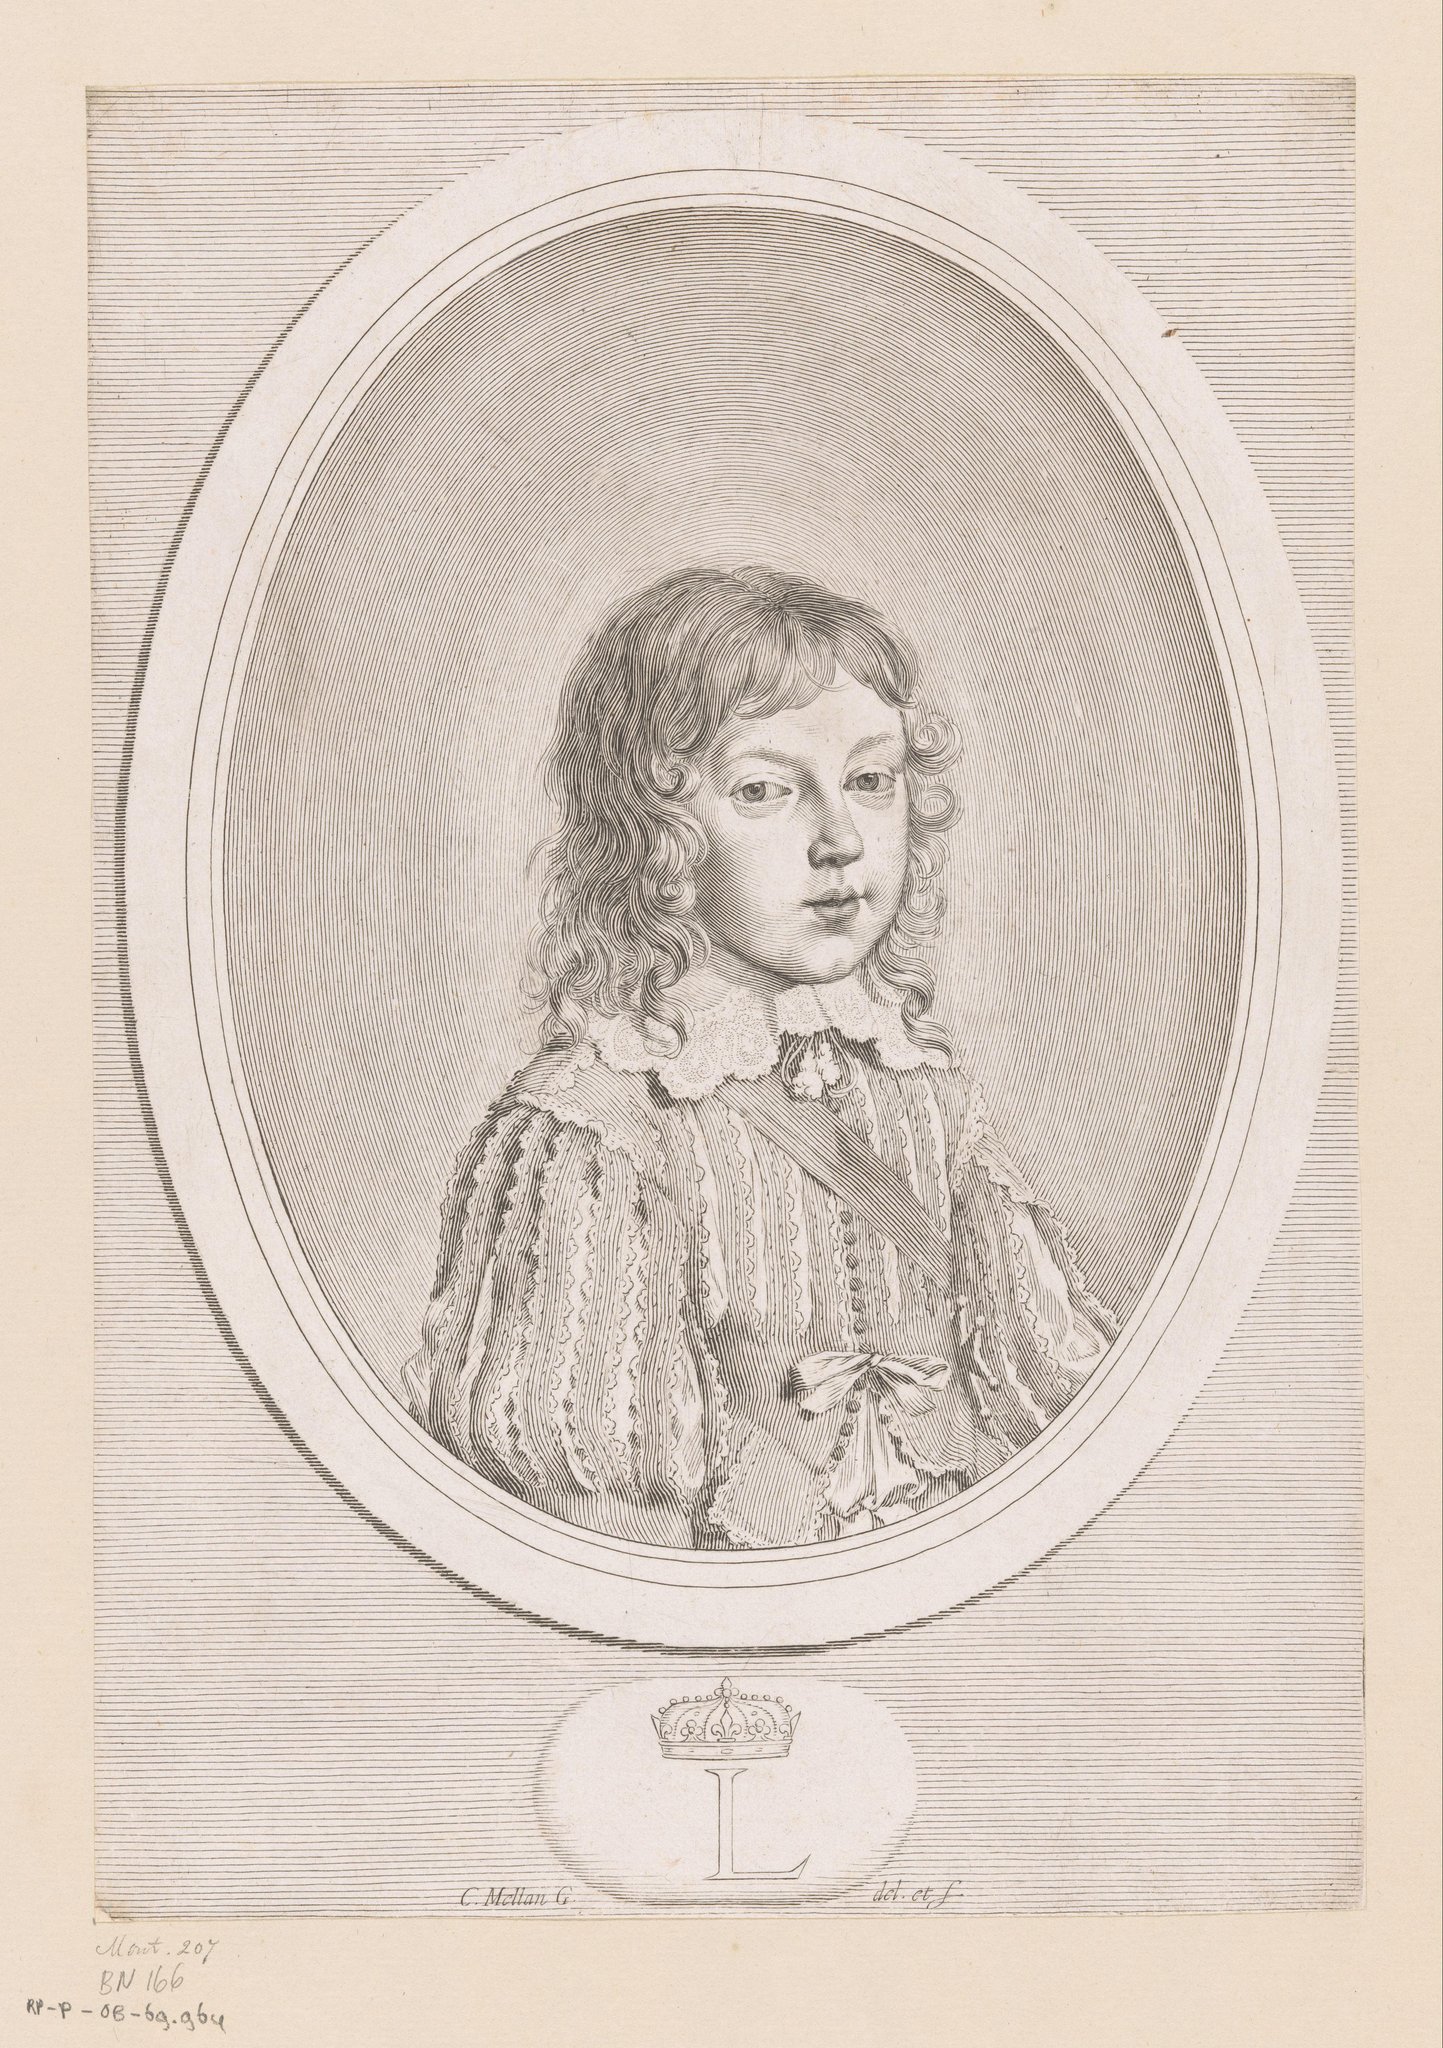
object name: print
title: Portret van Lodewijk XIV, koning van Frankrijk, als kind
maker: claude mellan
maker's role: draughtsman, print maker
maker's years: 1598-1688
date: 1643-1688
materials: paper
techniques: engraving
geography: france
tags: lodewijk xiv (koning van frankrijk), historical persons, king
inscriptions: collector's mark: Lugt 240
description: Een vergelijkbare tekening door Mellan bevindt zich in de collectie van de Hermitage te Sint-Petersburg, inv.nr. 4620.